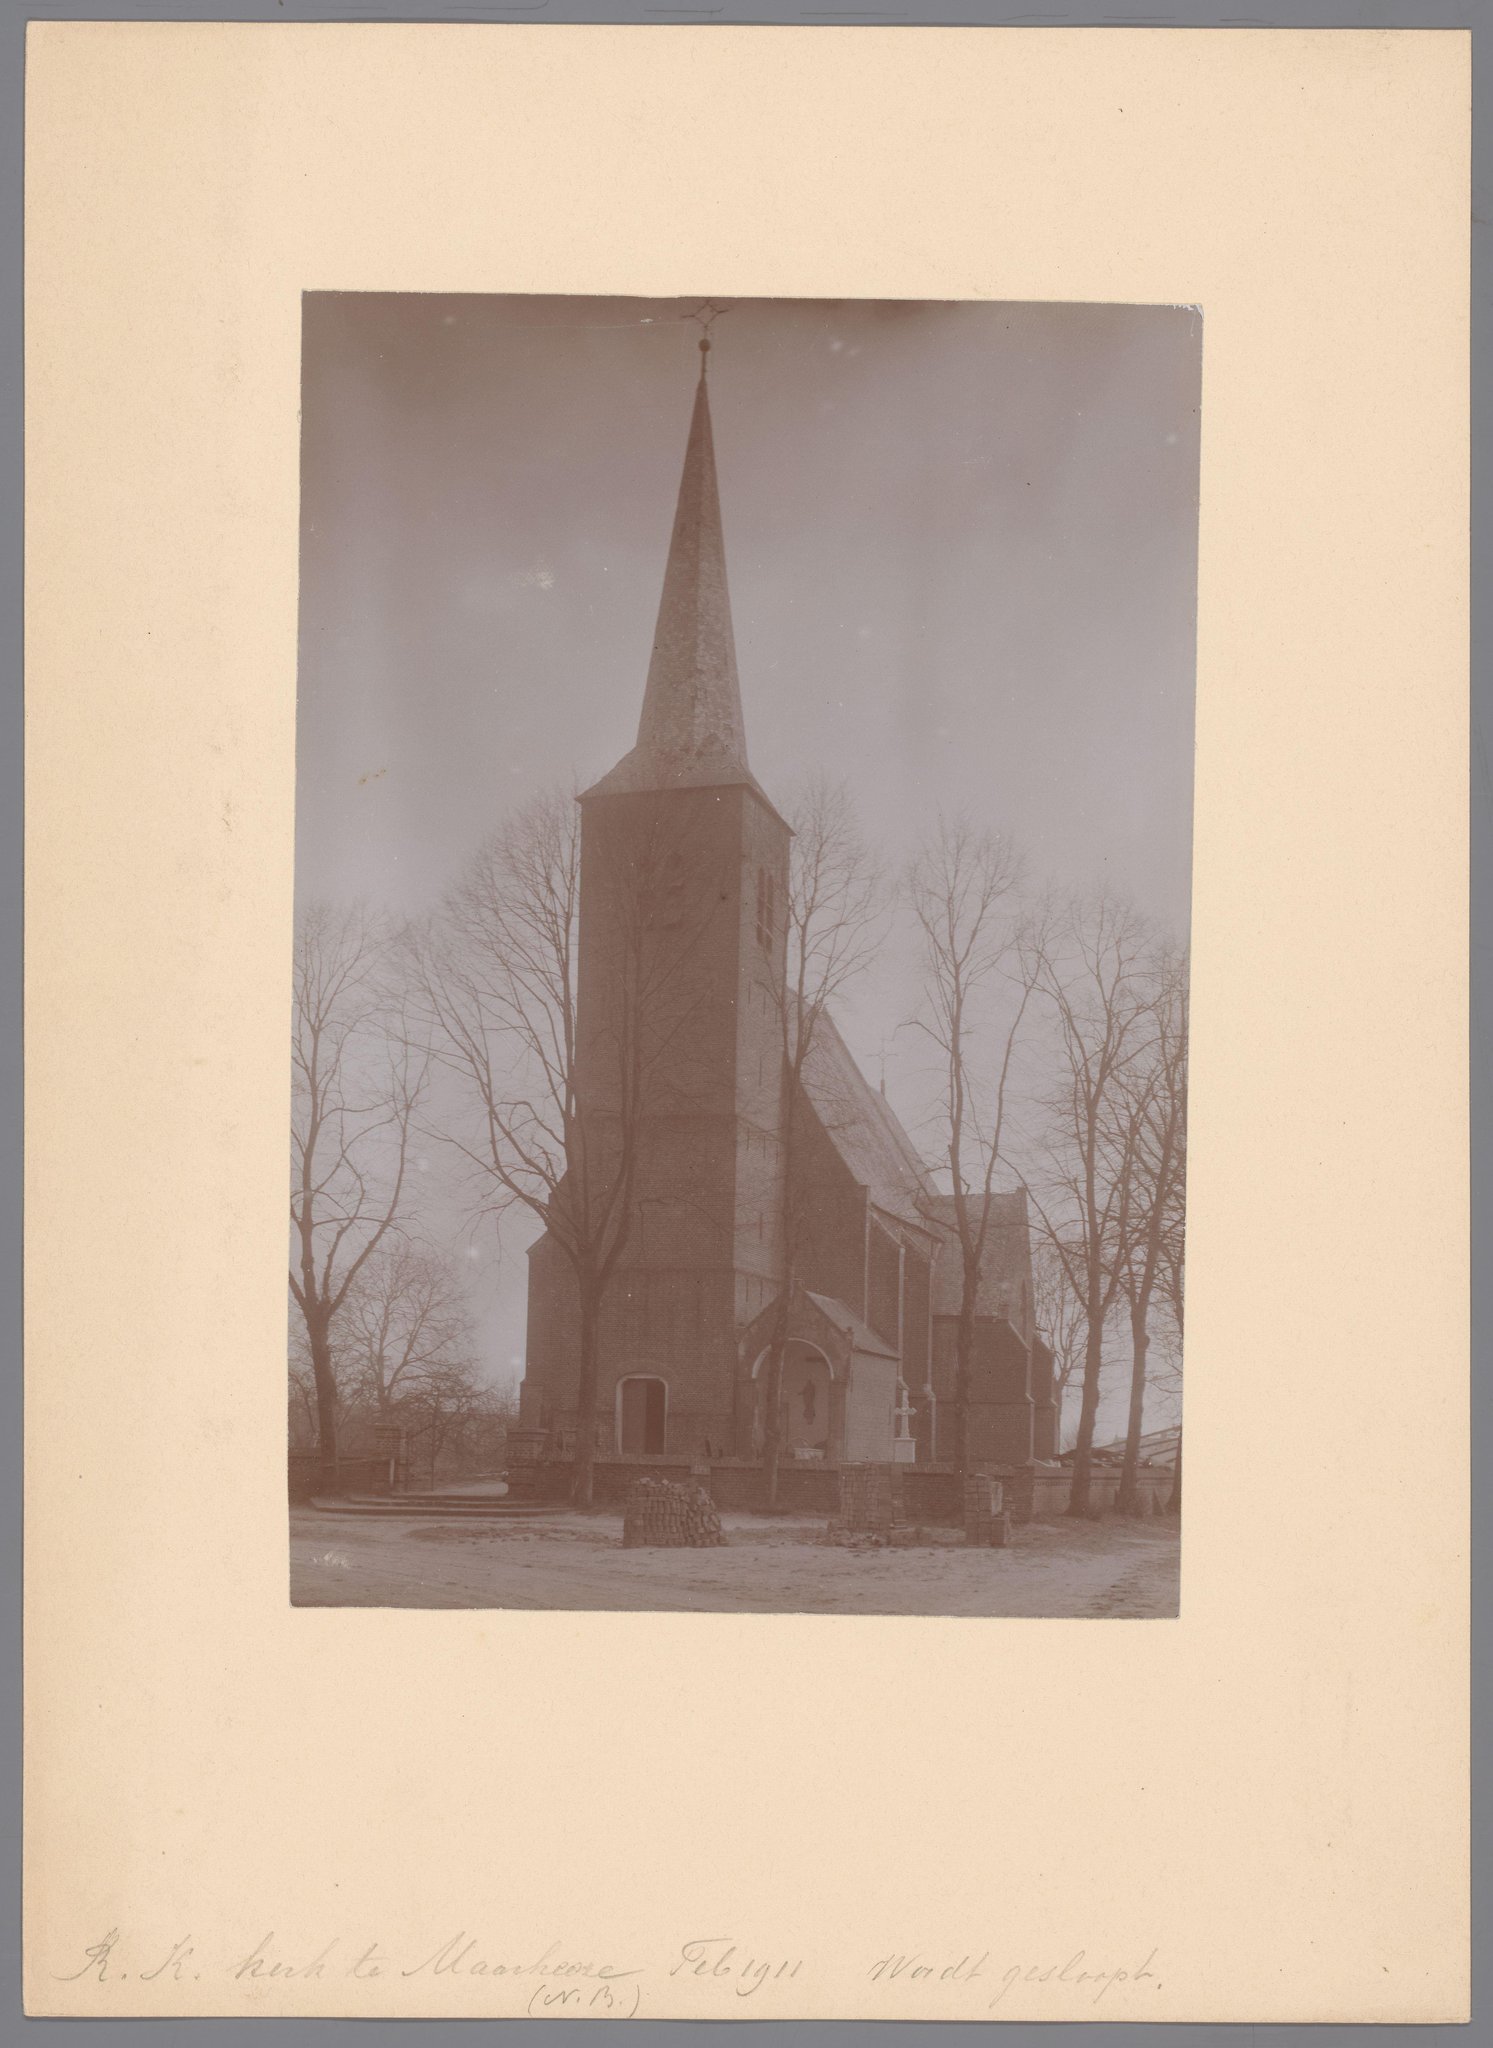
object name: photograph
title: Gezicht op de Sint-Gertrudiskerk te Maarheeze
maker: anoniem (monumentenzorg)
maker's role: fotograaf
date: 1911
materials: cardboard, photographic support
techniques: collodion silver print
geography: maarheeze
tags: church (exterior)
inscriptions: annotation: ‘R.K. kerk te Maarheeze (N.B.) Feb 1911/ wordt gesloopt’